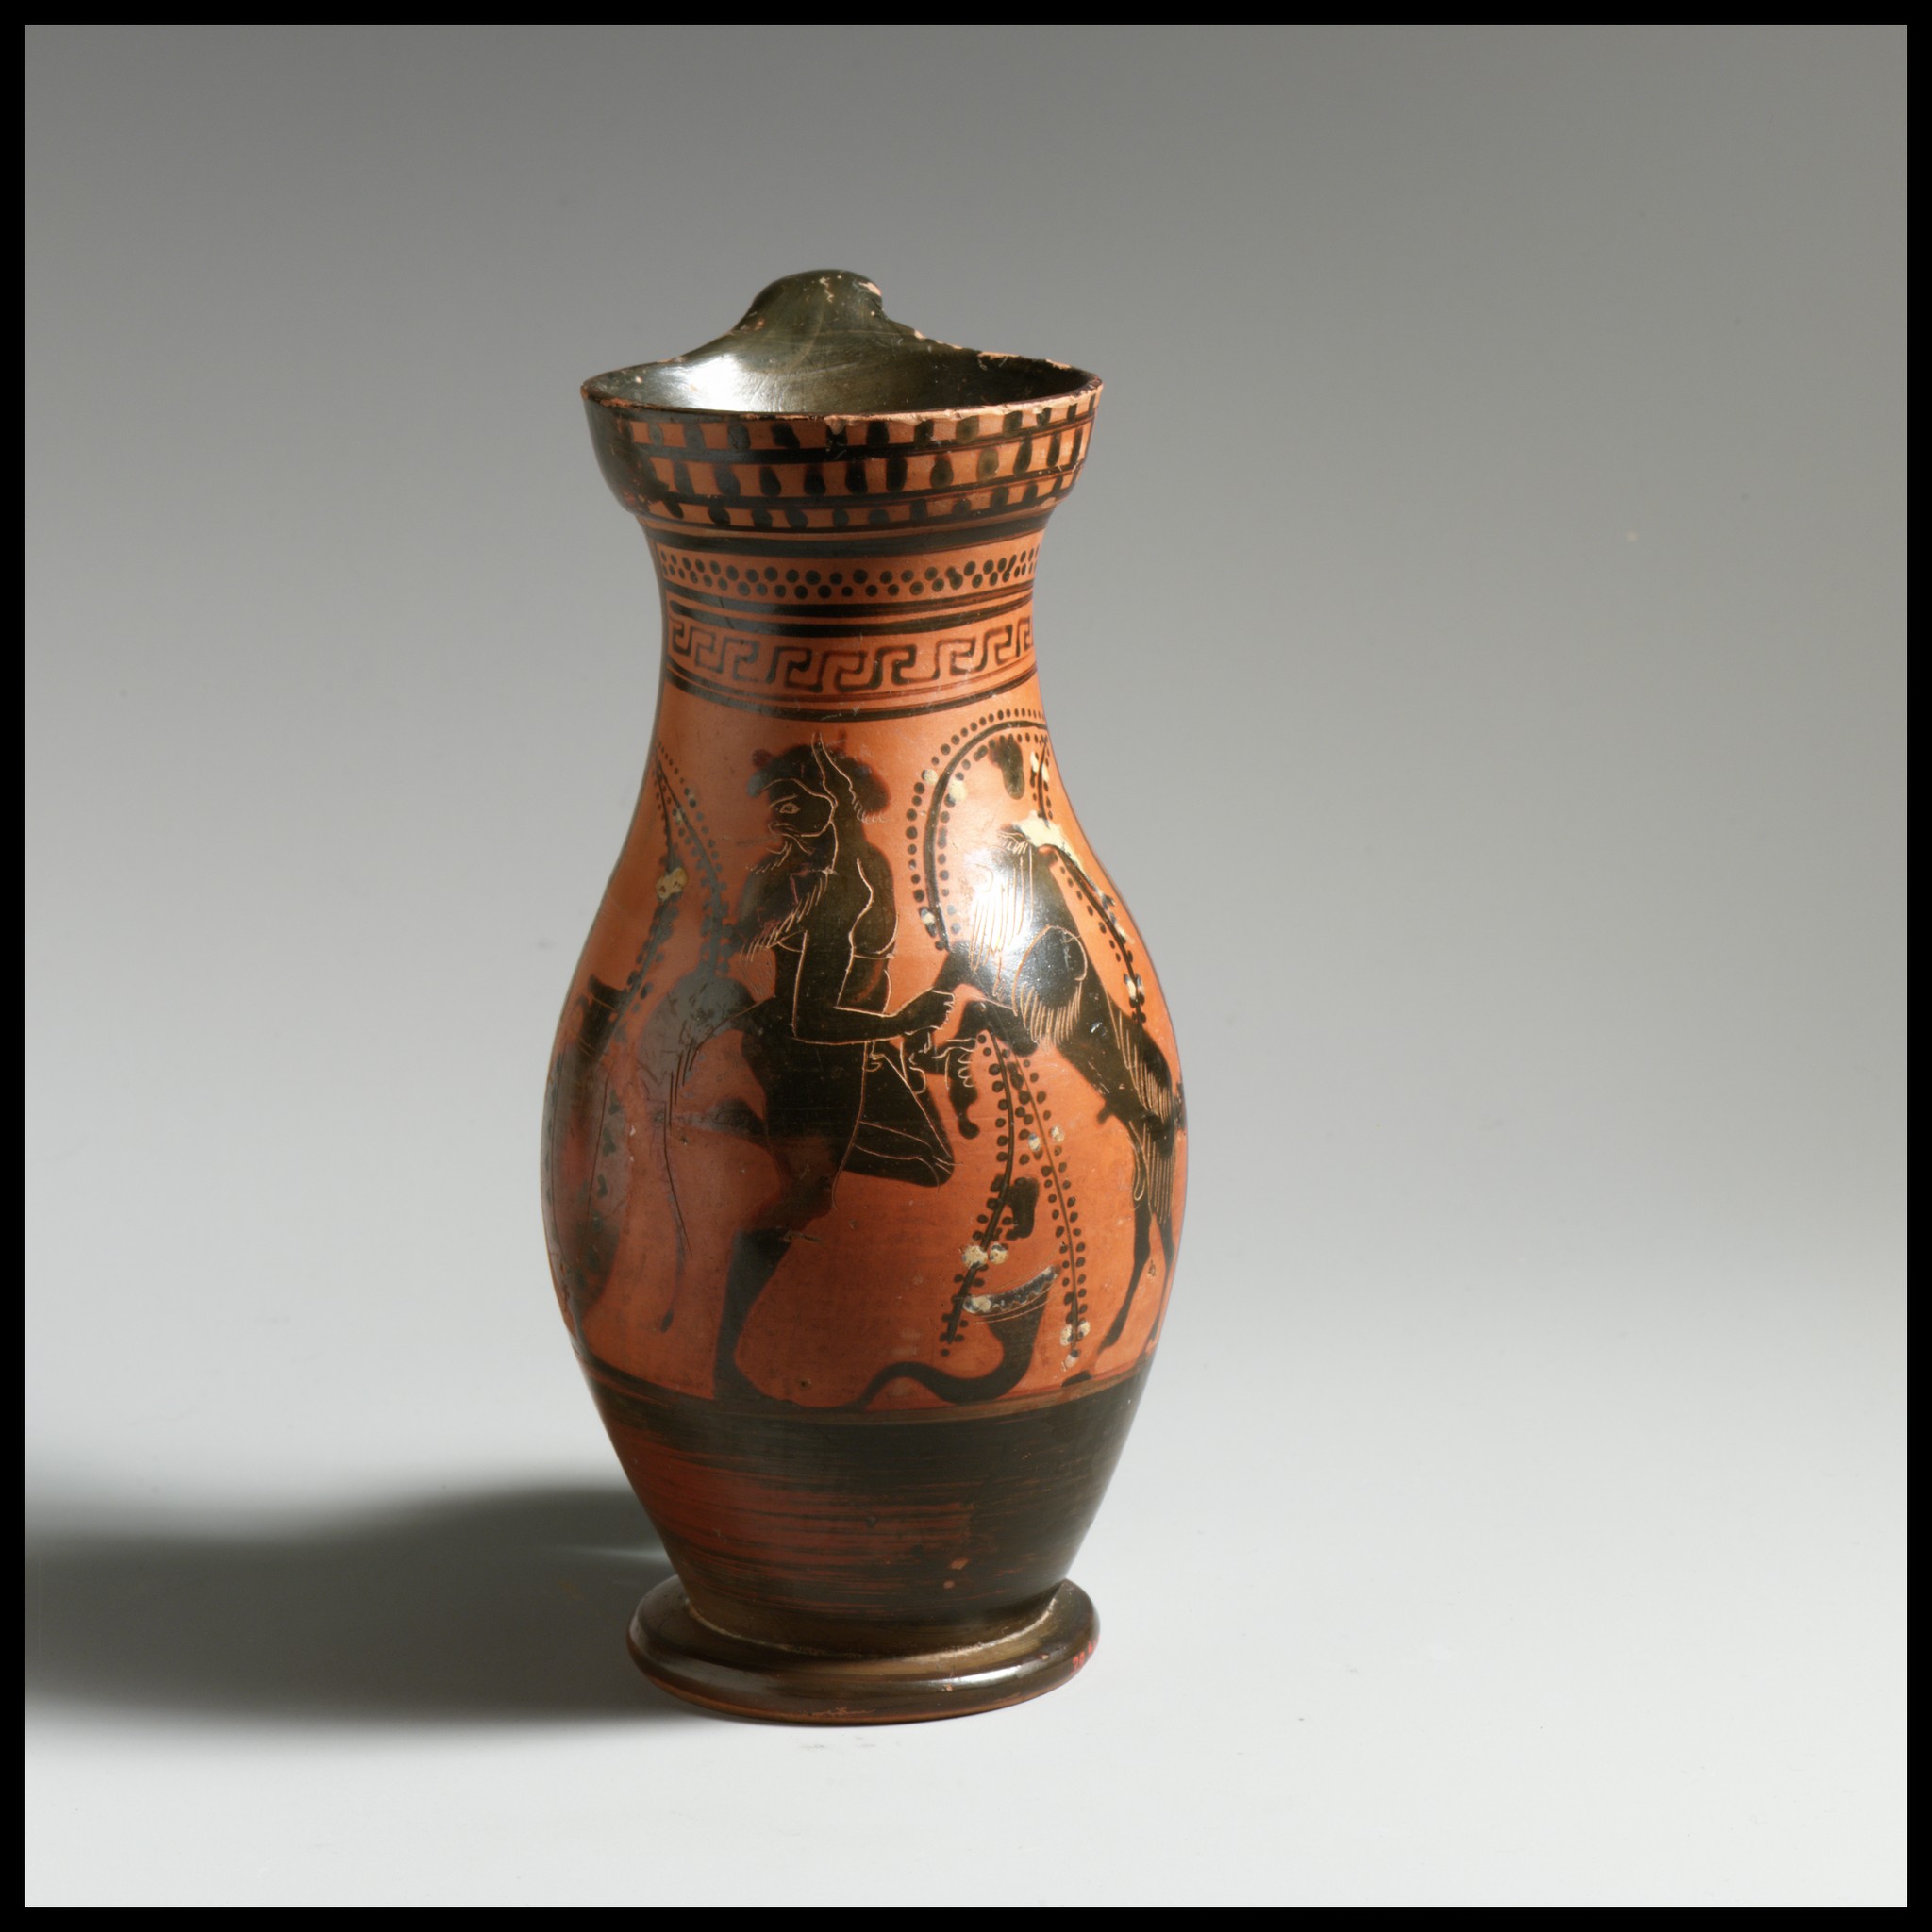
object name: oinochoe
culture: greek, attic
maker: athena painter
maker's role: artist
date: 600-401 BCE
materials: terracotta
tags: human figures,animals